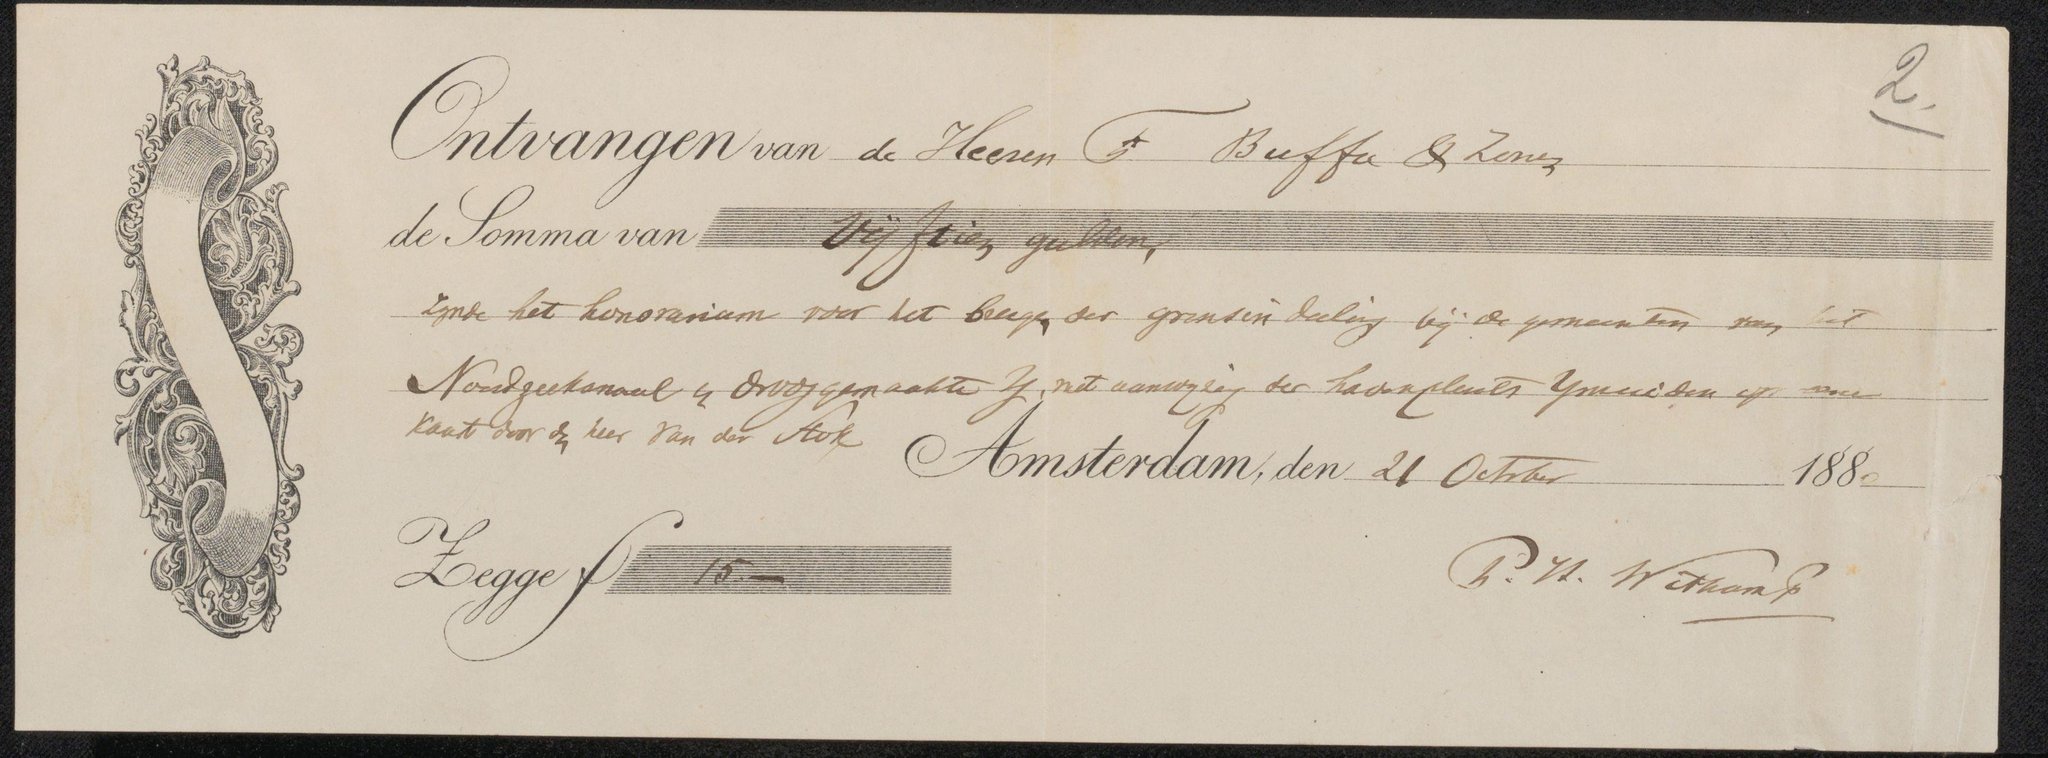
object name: ontvangstbewijs, kwitantie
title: Kwitantie voor Pieter Harmen Witkamp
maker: pieter harmen witkamp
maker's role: cartograaf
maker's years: 1816-1892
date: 1880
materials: ink, paper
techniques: pen, printing, writing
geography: amsterdam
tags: money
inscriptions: collector's mark: Lugt 2233